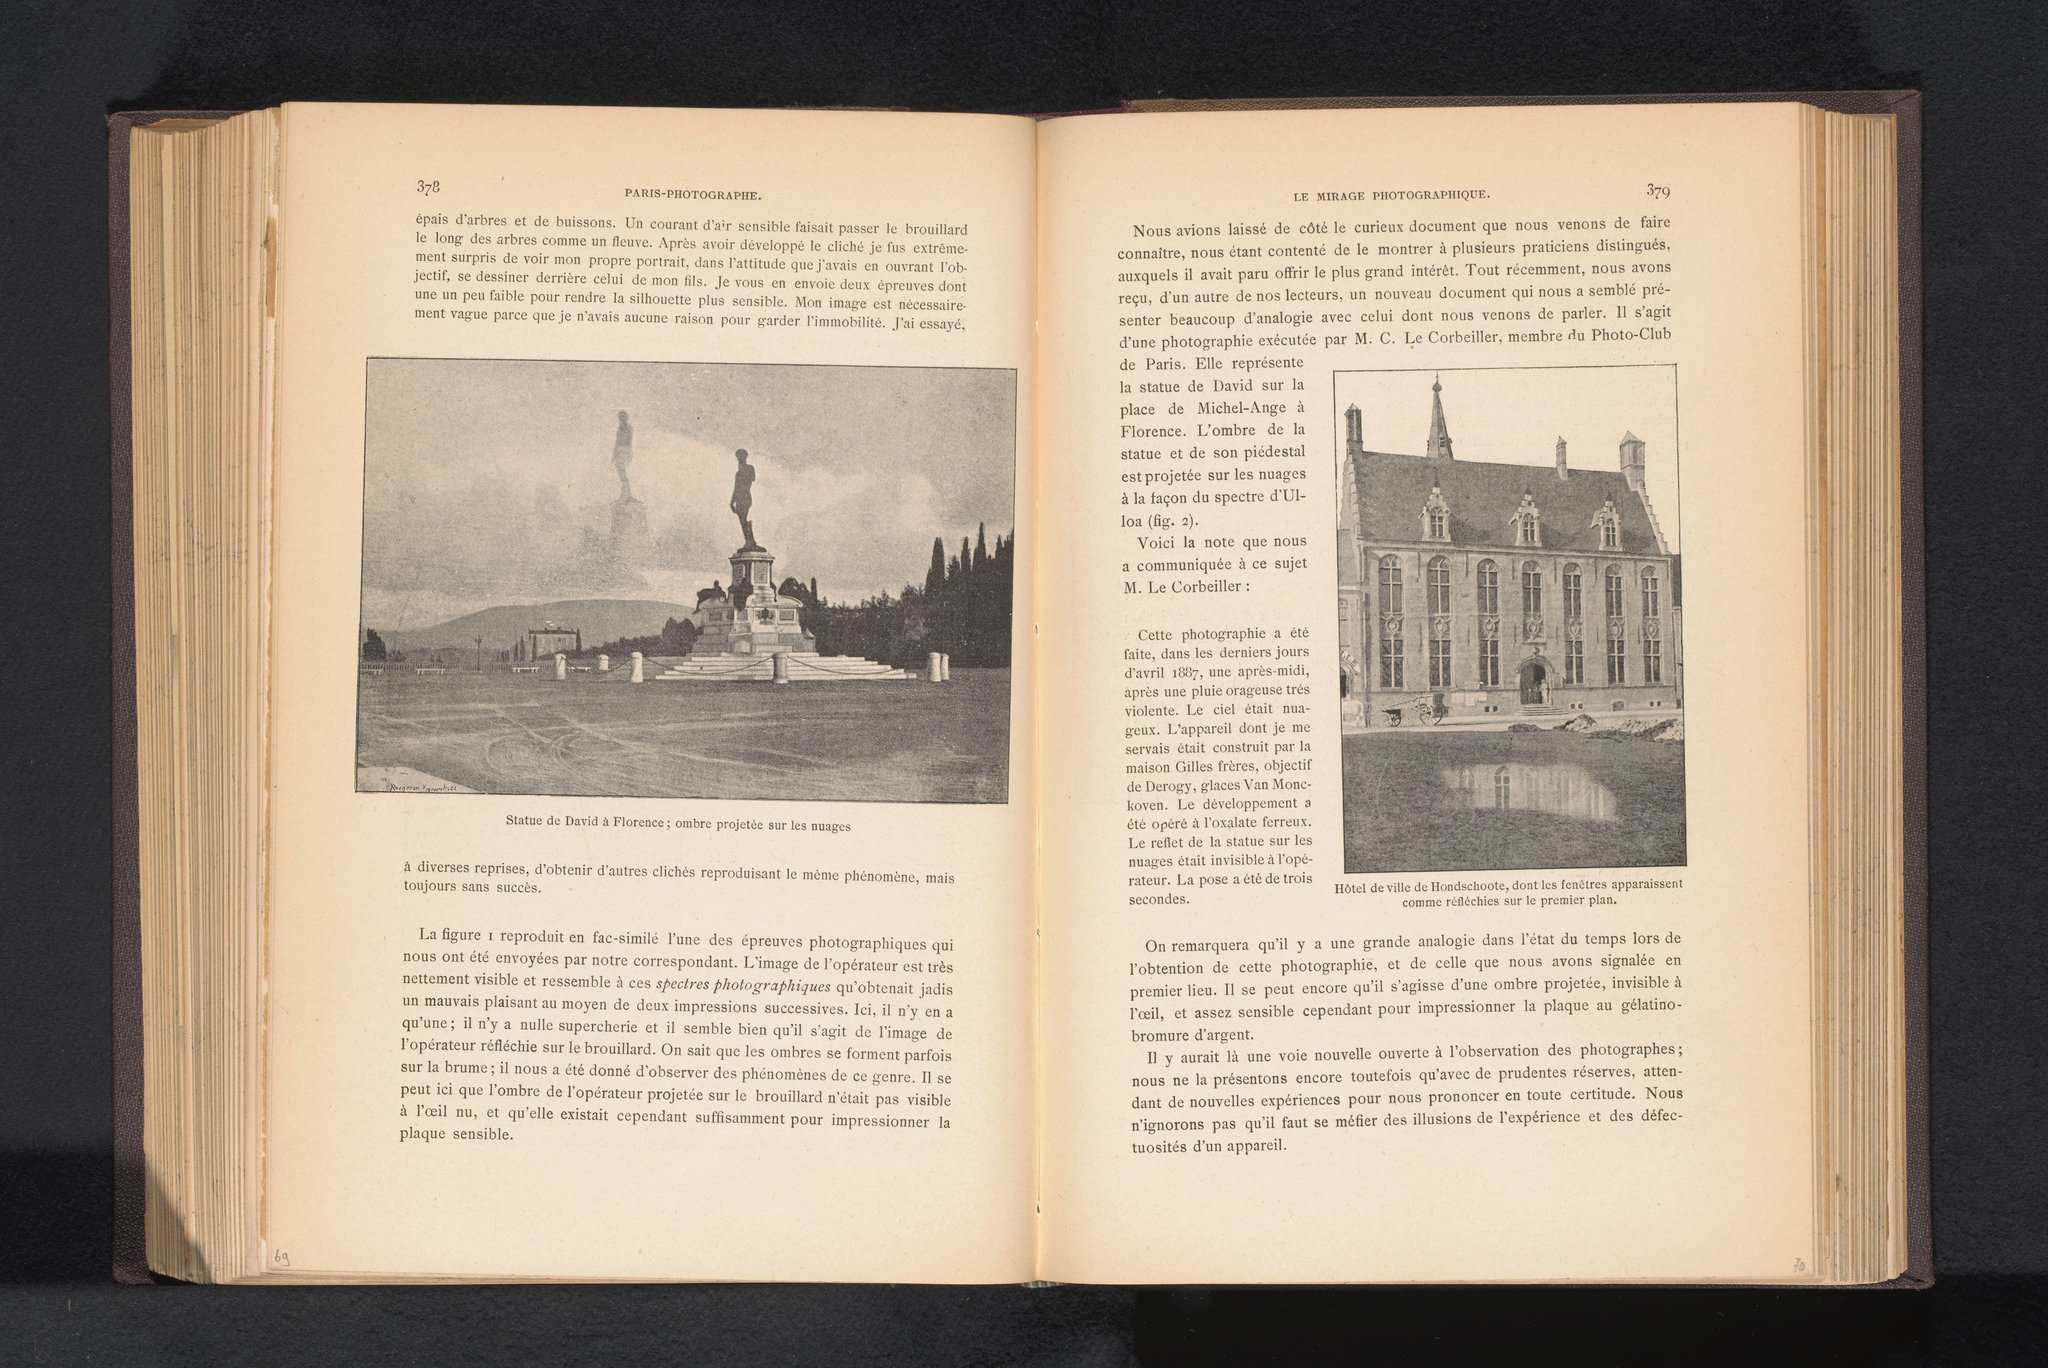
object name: page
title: Gezicht op stadhuis van Hondschoote met een reflectie in een waterplas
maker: Anonymous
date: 1882-1892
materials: paper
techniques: autotype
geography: hondschoote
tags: townhall